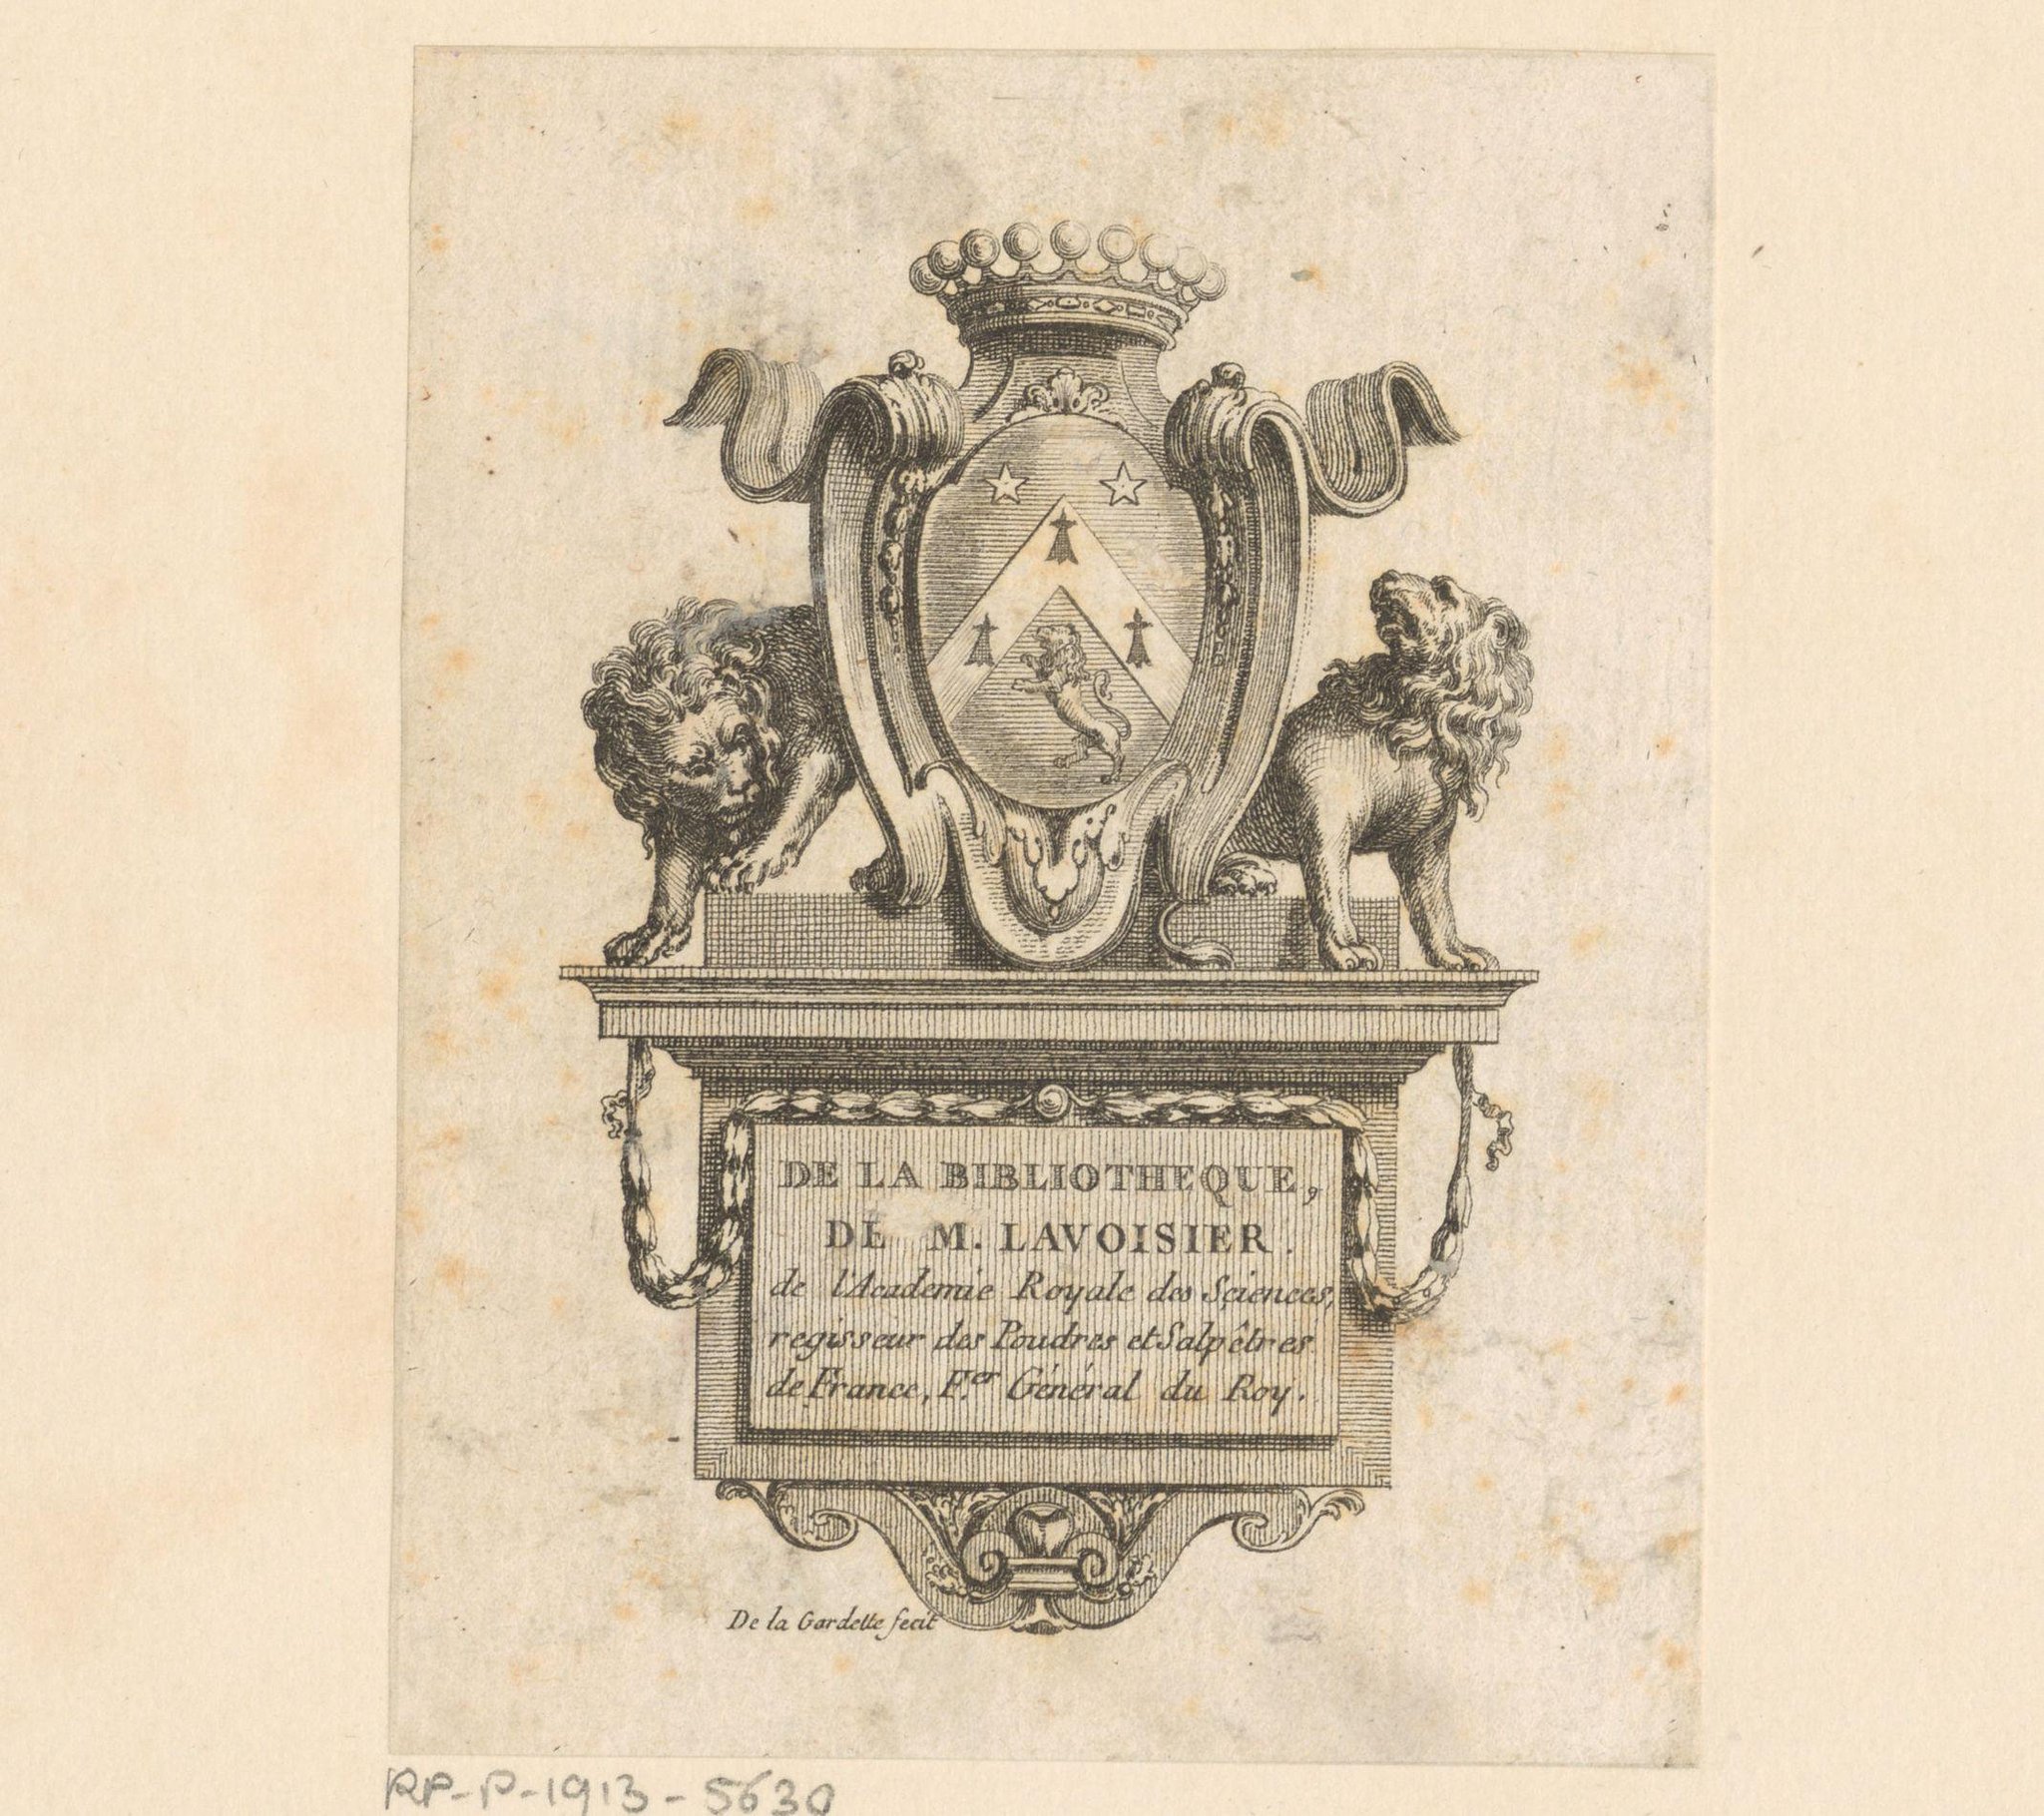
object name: bookplate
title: De la bibliothèque de M. Lavoisier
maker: pierre claude delagardette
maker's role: print maker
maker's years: 1743-1782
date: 1775-1785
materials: paper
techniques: etching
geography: france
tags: paris, beasts of prey, predatory animals: lion, armorial bearing, heraldry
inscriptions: collector's mark: Lugt 2760, collector's mark: Lugt 2233